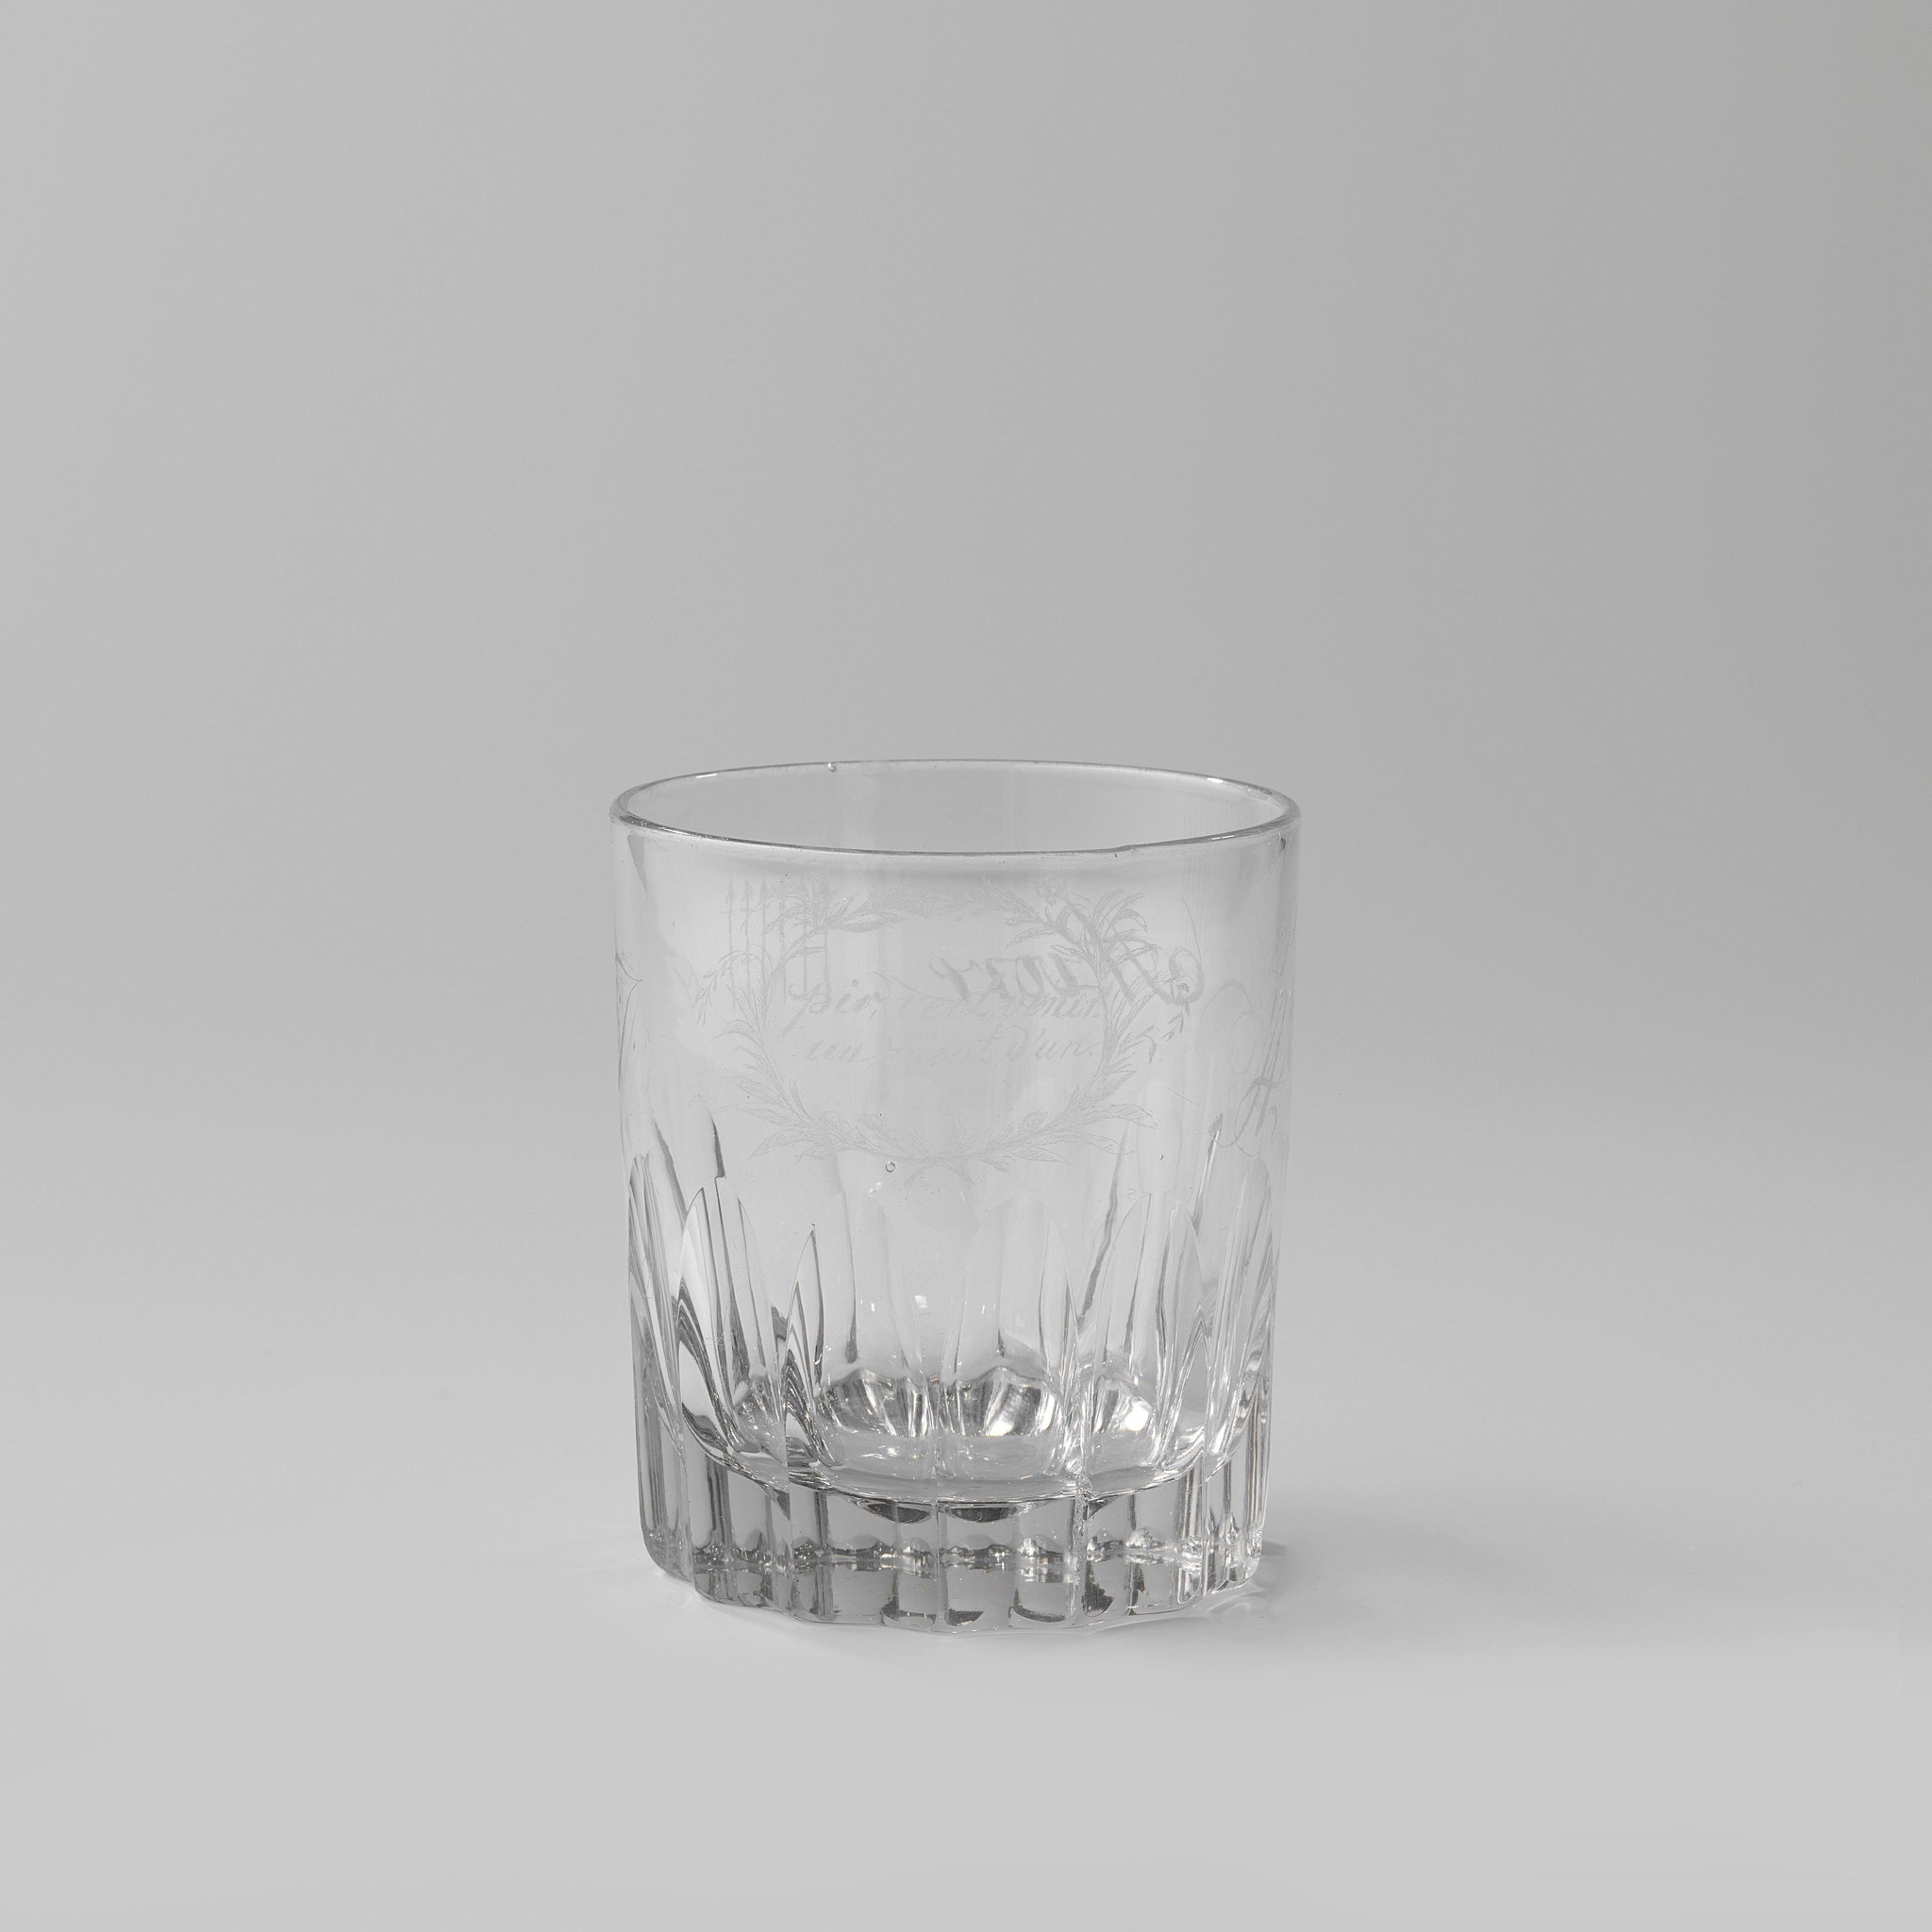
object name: cup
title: Beker met het opschrift: pir, vent, venir. un, vient, d'un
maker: daniël henriques de castro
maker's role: glasgraveur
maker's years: 1806-1863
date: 1850-1863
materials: glass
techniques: diamond point engraving, glassblowing, grinding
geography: amsterdam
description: Platte bodem. In halve ovalen gefacetteerde onderzijde. Cylindervormig lichaam, waarop in een ovaal medaillon, omgeven door een bladrank de woorden pir, vent, venir. un, vient, d'un. ( ). Rechts van het medaillon, omlopend, enkele losse letters, het woord Avore, zes naar boven gerichte pijlen en twee, in elkaar geschreven, G's. Links boven de pijlen de signatuur D.H.de C.